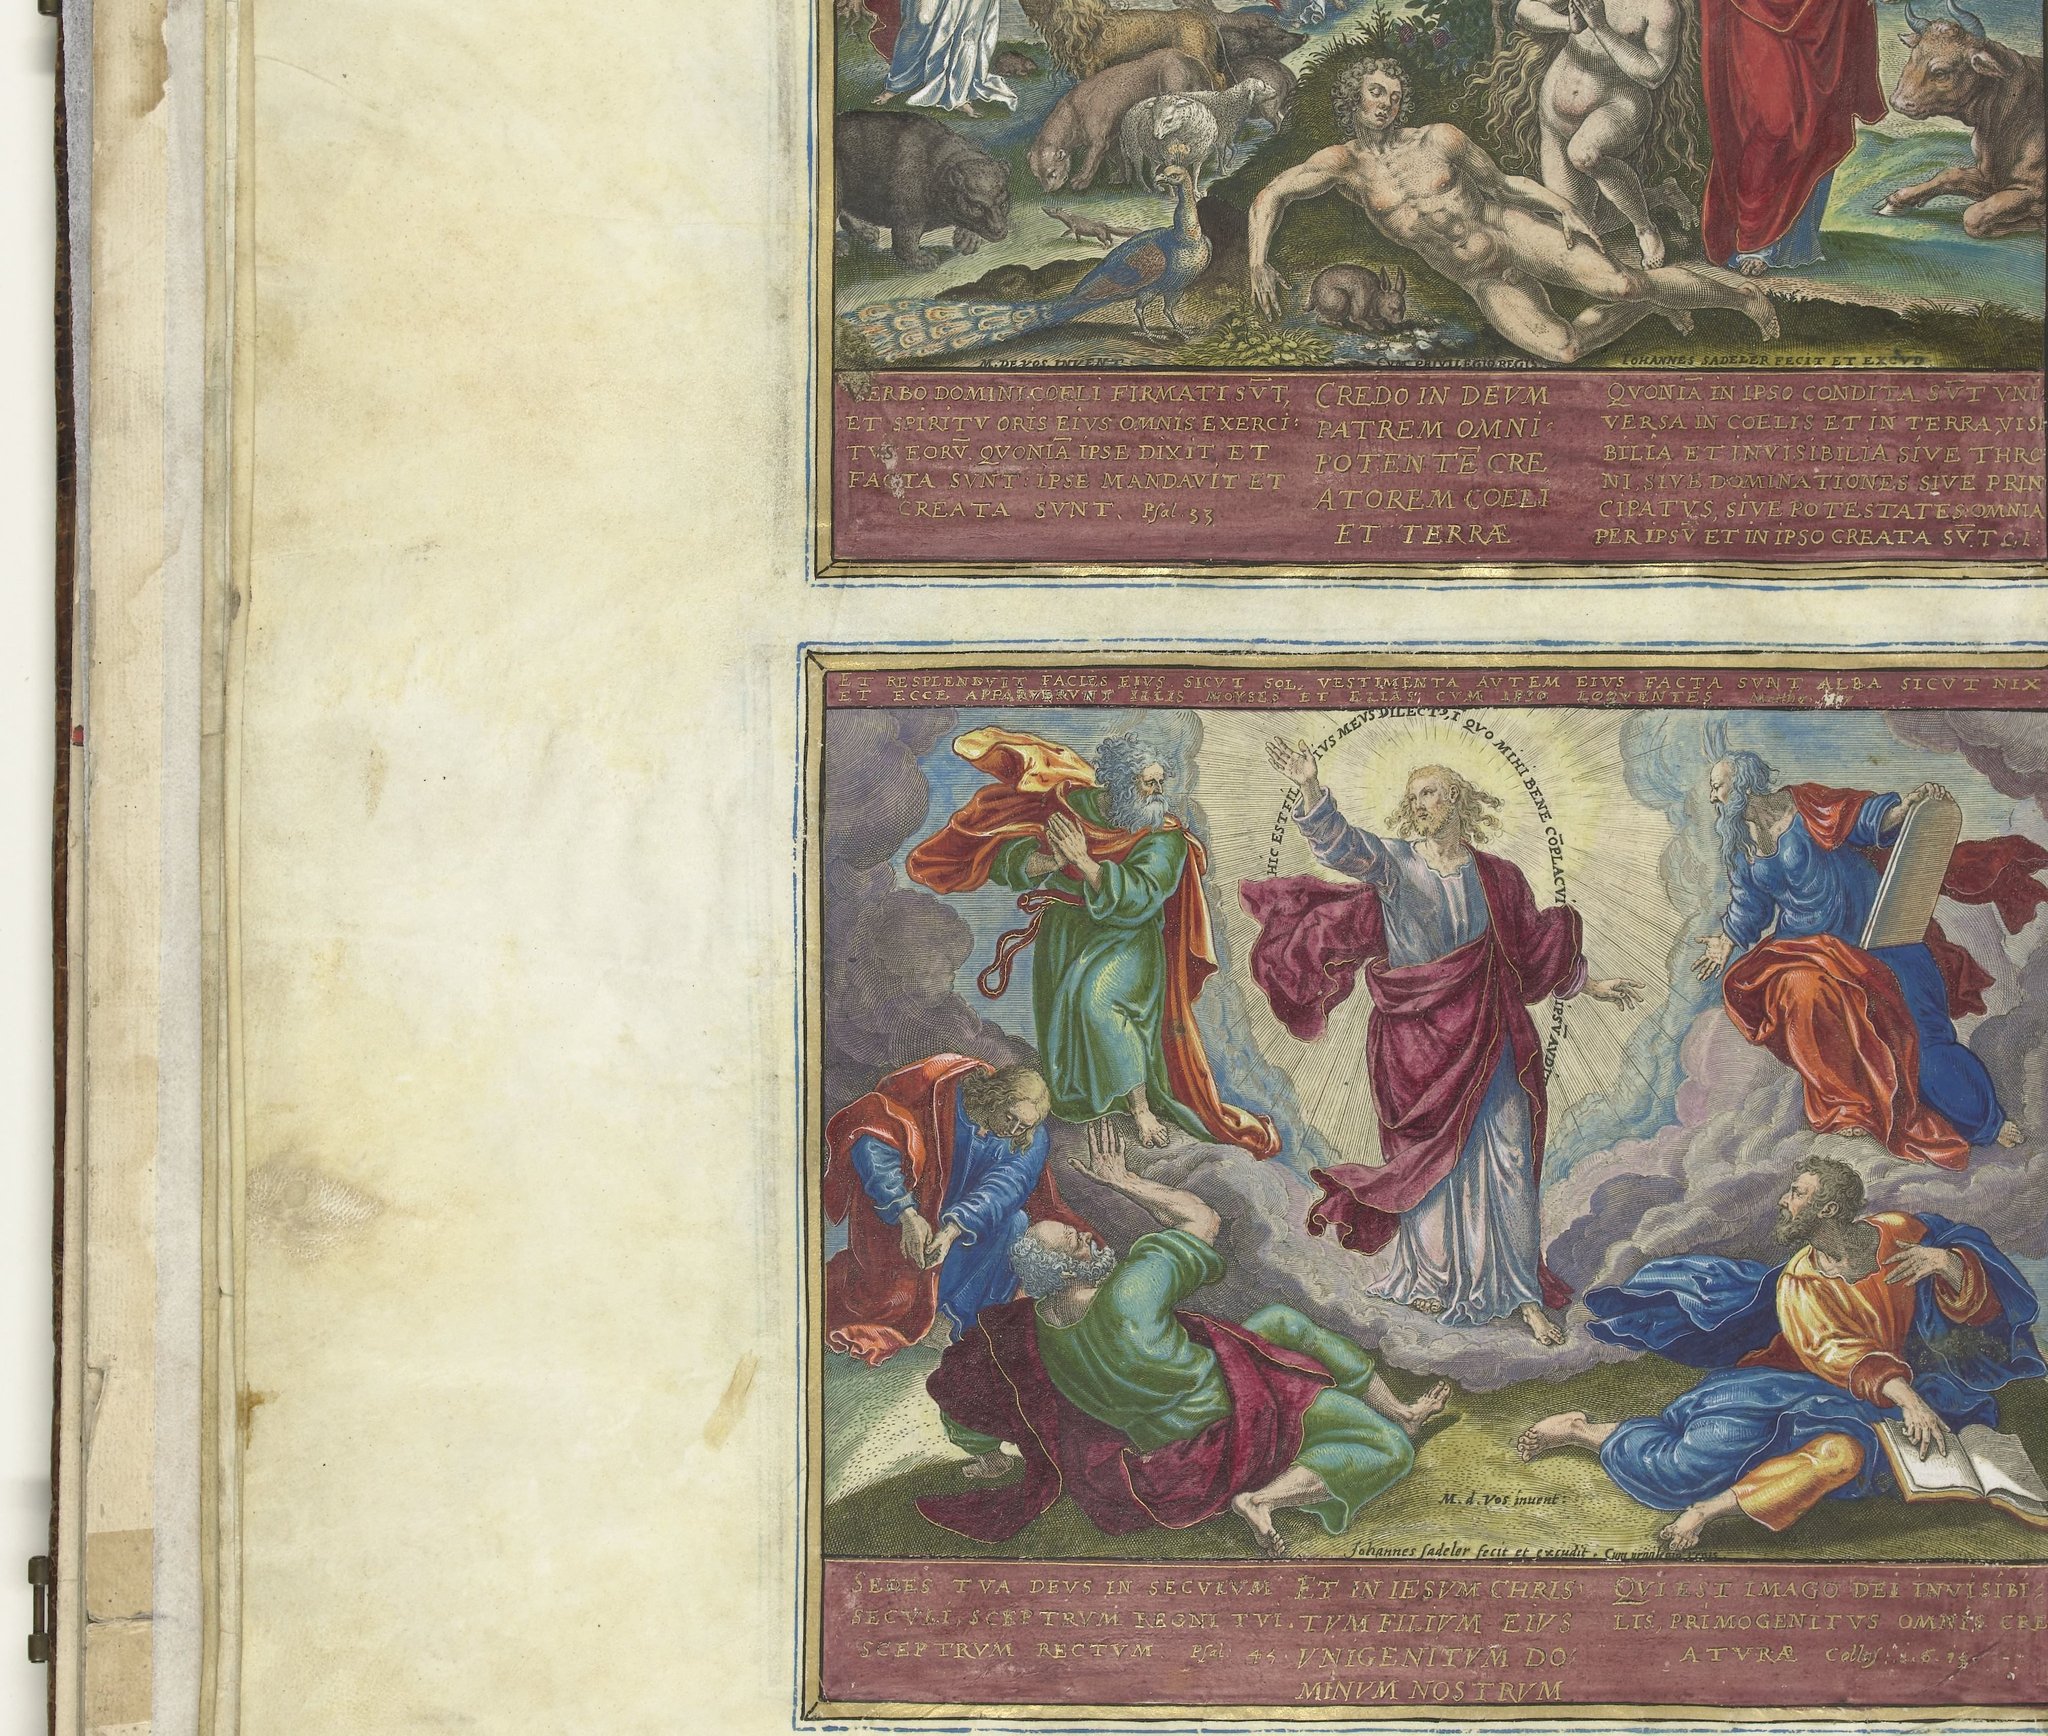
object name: print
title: Et in Jesum Christum filium eius unigenitum Dominum nostrum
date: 1579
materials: paper, parchment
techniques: engraving, hand coloring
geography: cologne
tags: 'et in jesum christum filium eius' ~ articles of faith, the transfiguration: moses and elijah appear on either side of christ on mount tabor (matthew 17:1-13; mark 9:2-13; luke 9:28-36)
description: Illustratie van het tweede geloofsartikel ([Ik geloof] in Jezus Christus, zijn enige Zoon, onze Heer) van de apostolische geloofsbelijdenis. De verheerlijking op de berg: Christus' gezicht straalt als de zon. Elia en Mozes verschijnen aan weerszijden van Christus en spreken met hem. Op de berg zitten Johannes, Petrus en Jakobus. Boven de voorstelling een verwijzing naar de Bijbeltekst in Mat. 17:2-3. Onder de voorstelling twee Bijbelteksten en het tweede geloofsartikel uit de apostolische geloofsbelijdenis in het Latijn. Deze prent maakt deel uit van een album.